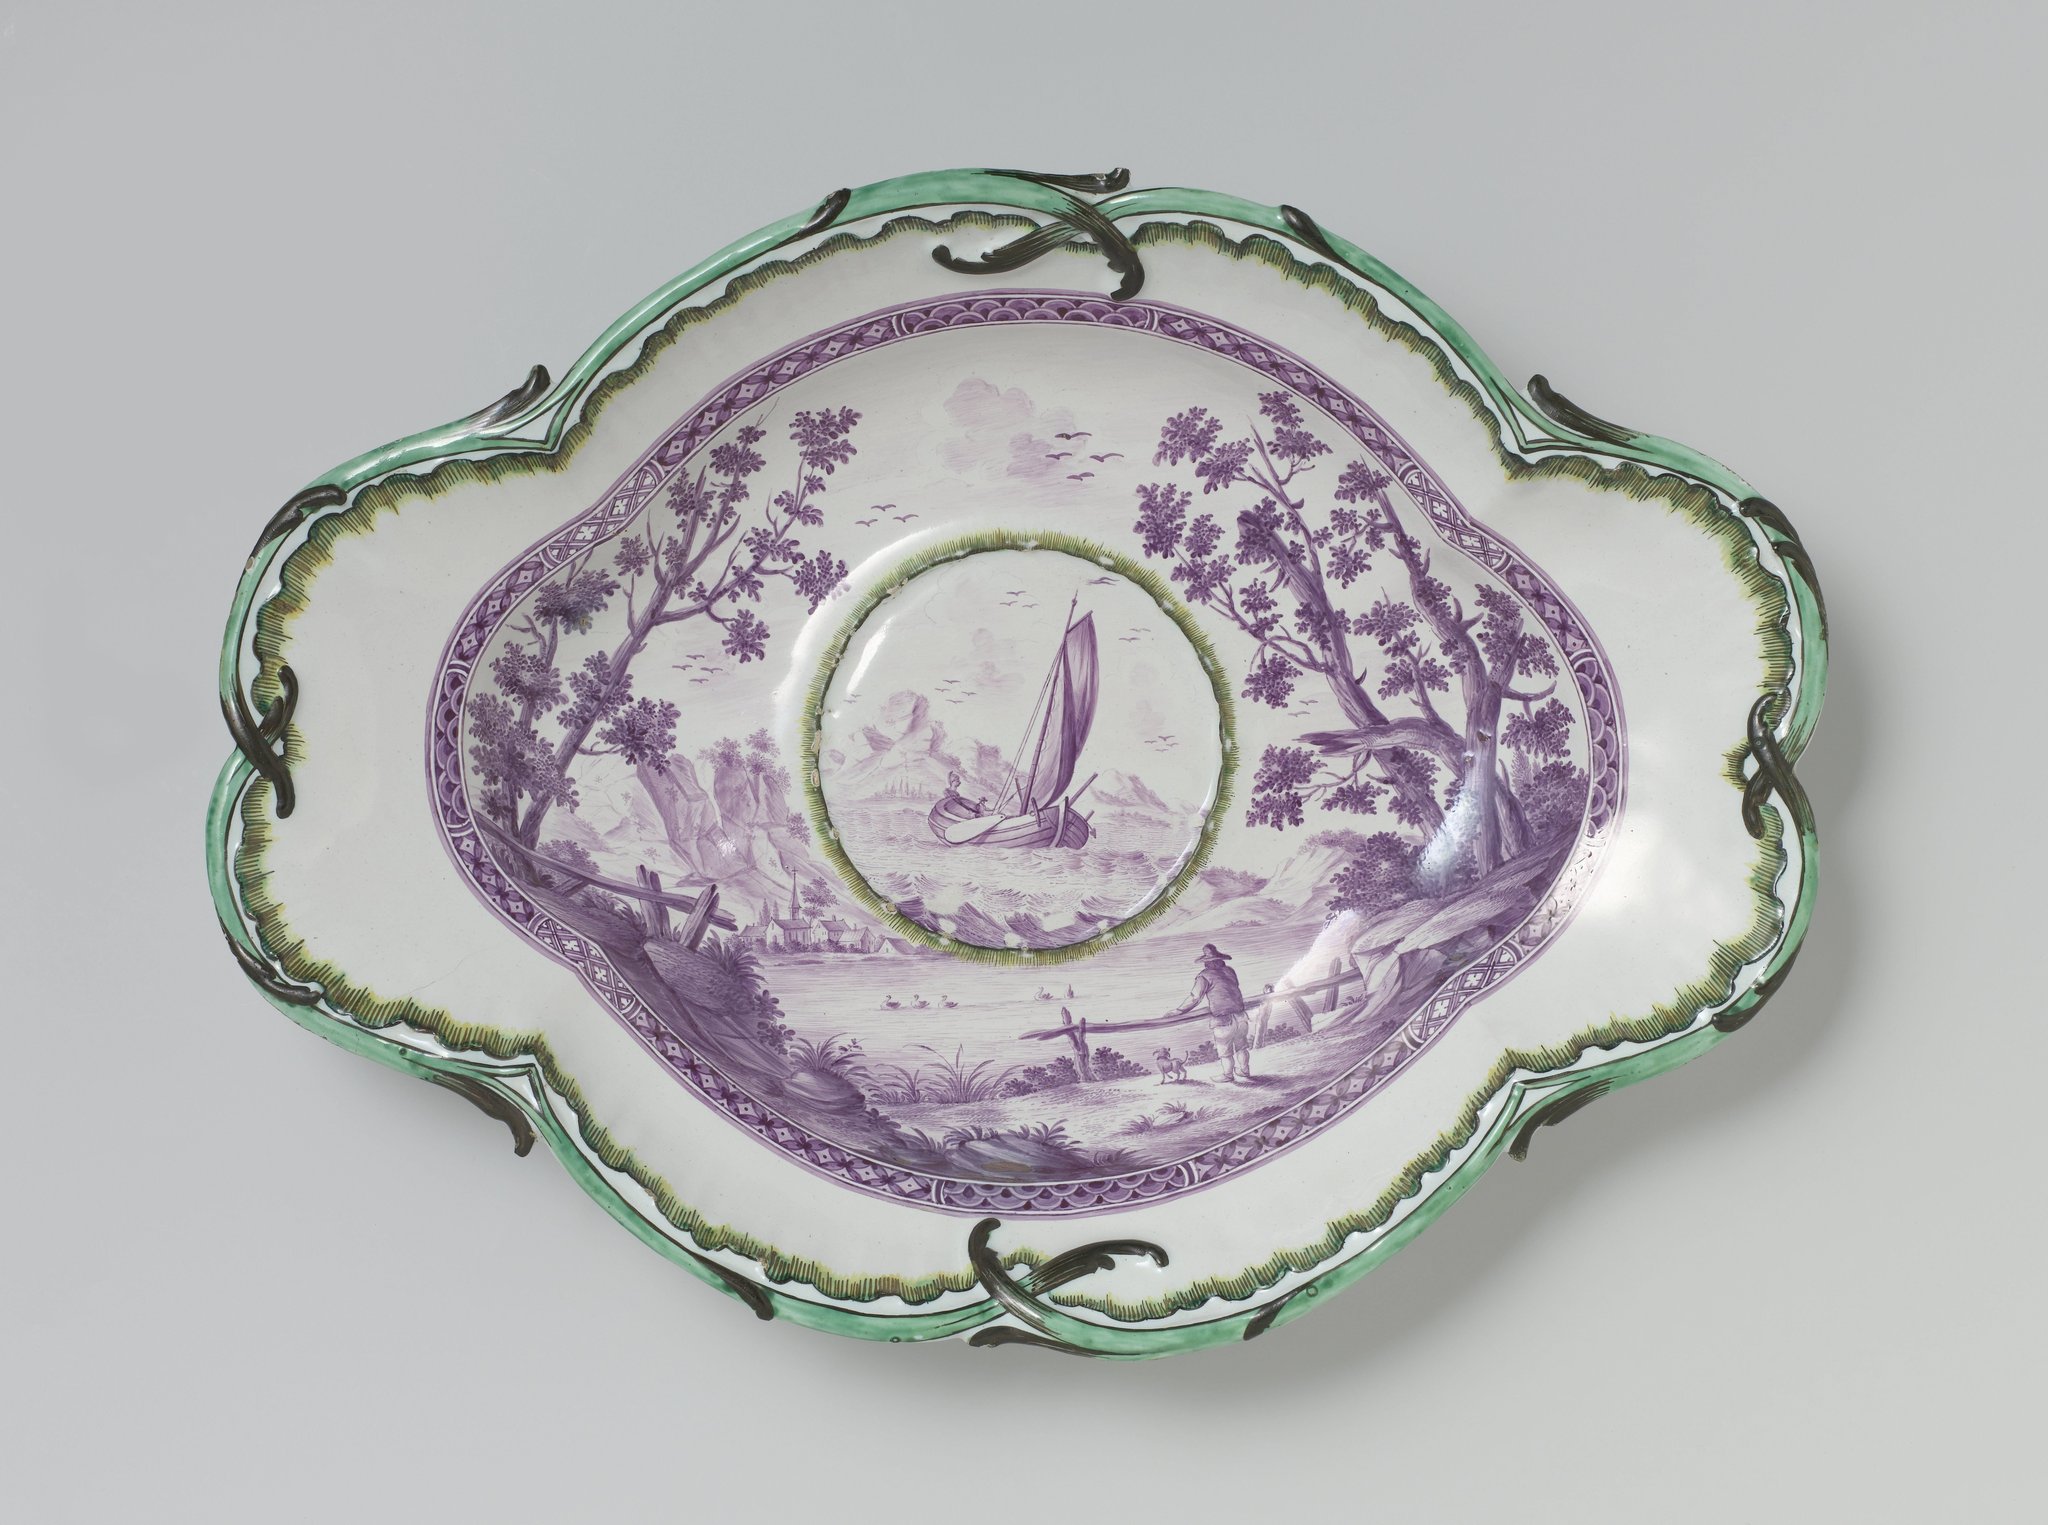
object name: bekken schaal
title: Ewer and basin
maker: johan van kerkhoff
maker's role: fayencier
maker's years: 1716-1773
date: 1760-1770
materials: faience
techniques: kiln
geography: arnhem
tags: sailing-ship, sailing-boat, landscapes in the temperate zone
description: Although Delft was the most important centre for the faience industry, other towns and cities also had potteries. In 1759 the wine merchant Johan van Kerckhoff founded a faience factory in Arnhem. It produced imitations of Delftware, but also pieces with contemporary forms, such as this ewer and basin in a restrained Rococo style.